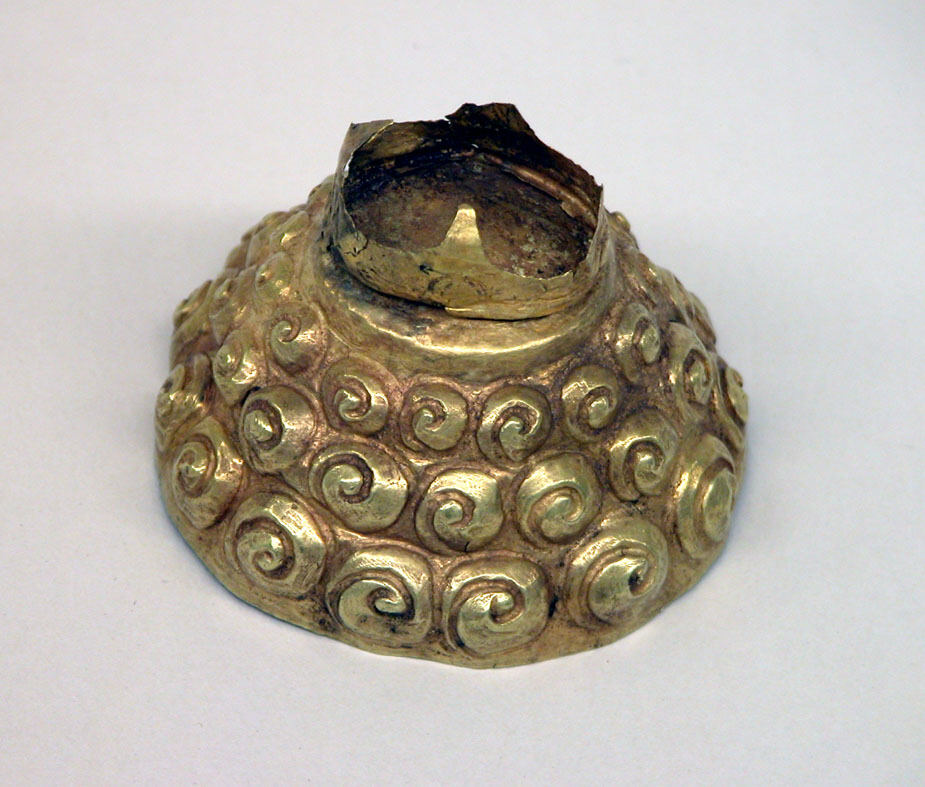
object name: cover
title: Ushnisha Cover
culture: indonesian, javanese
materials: gold